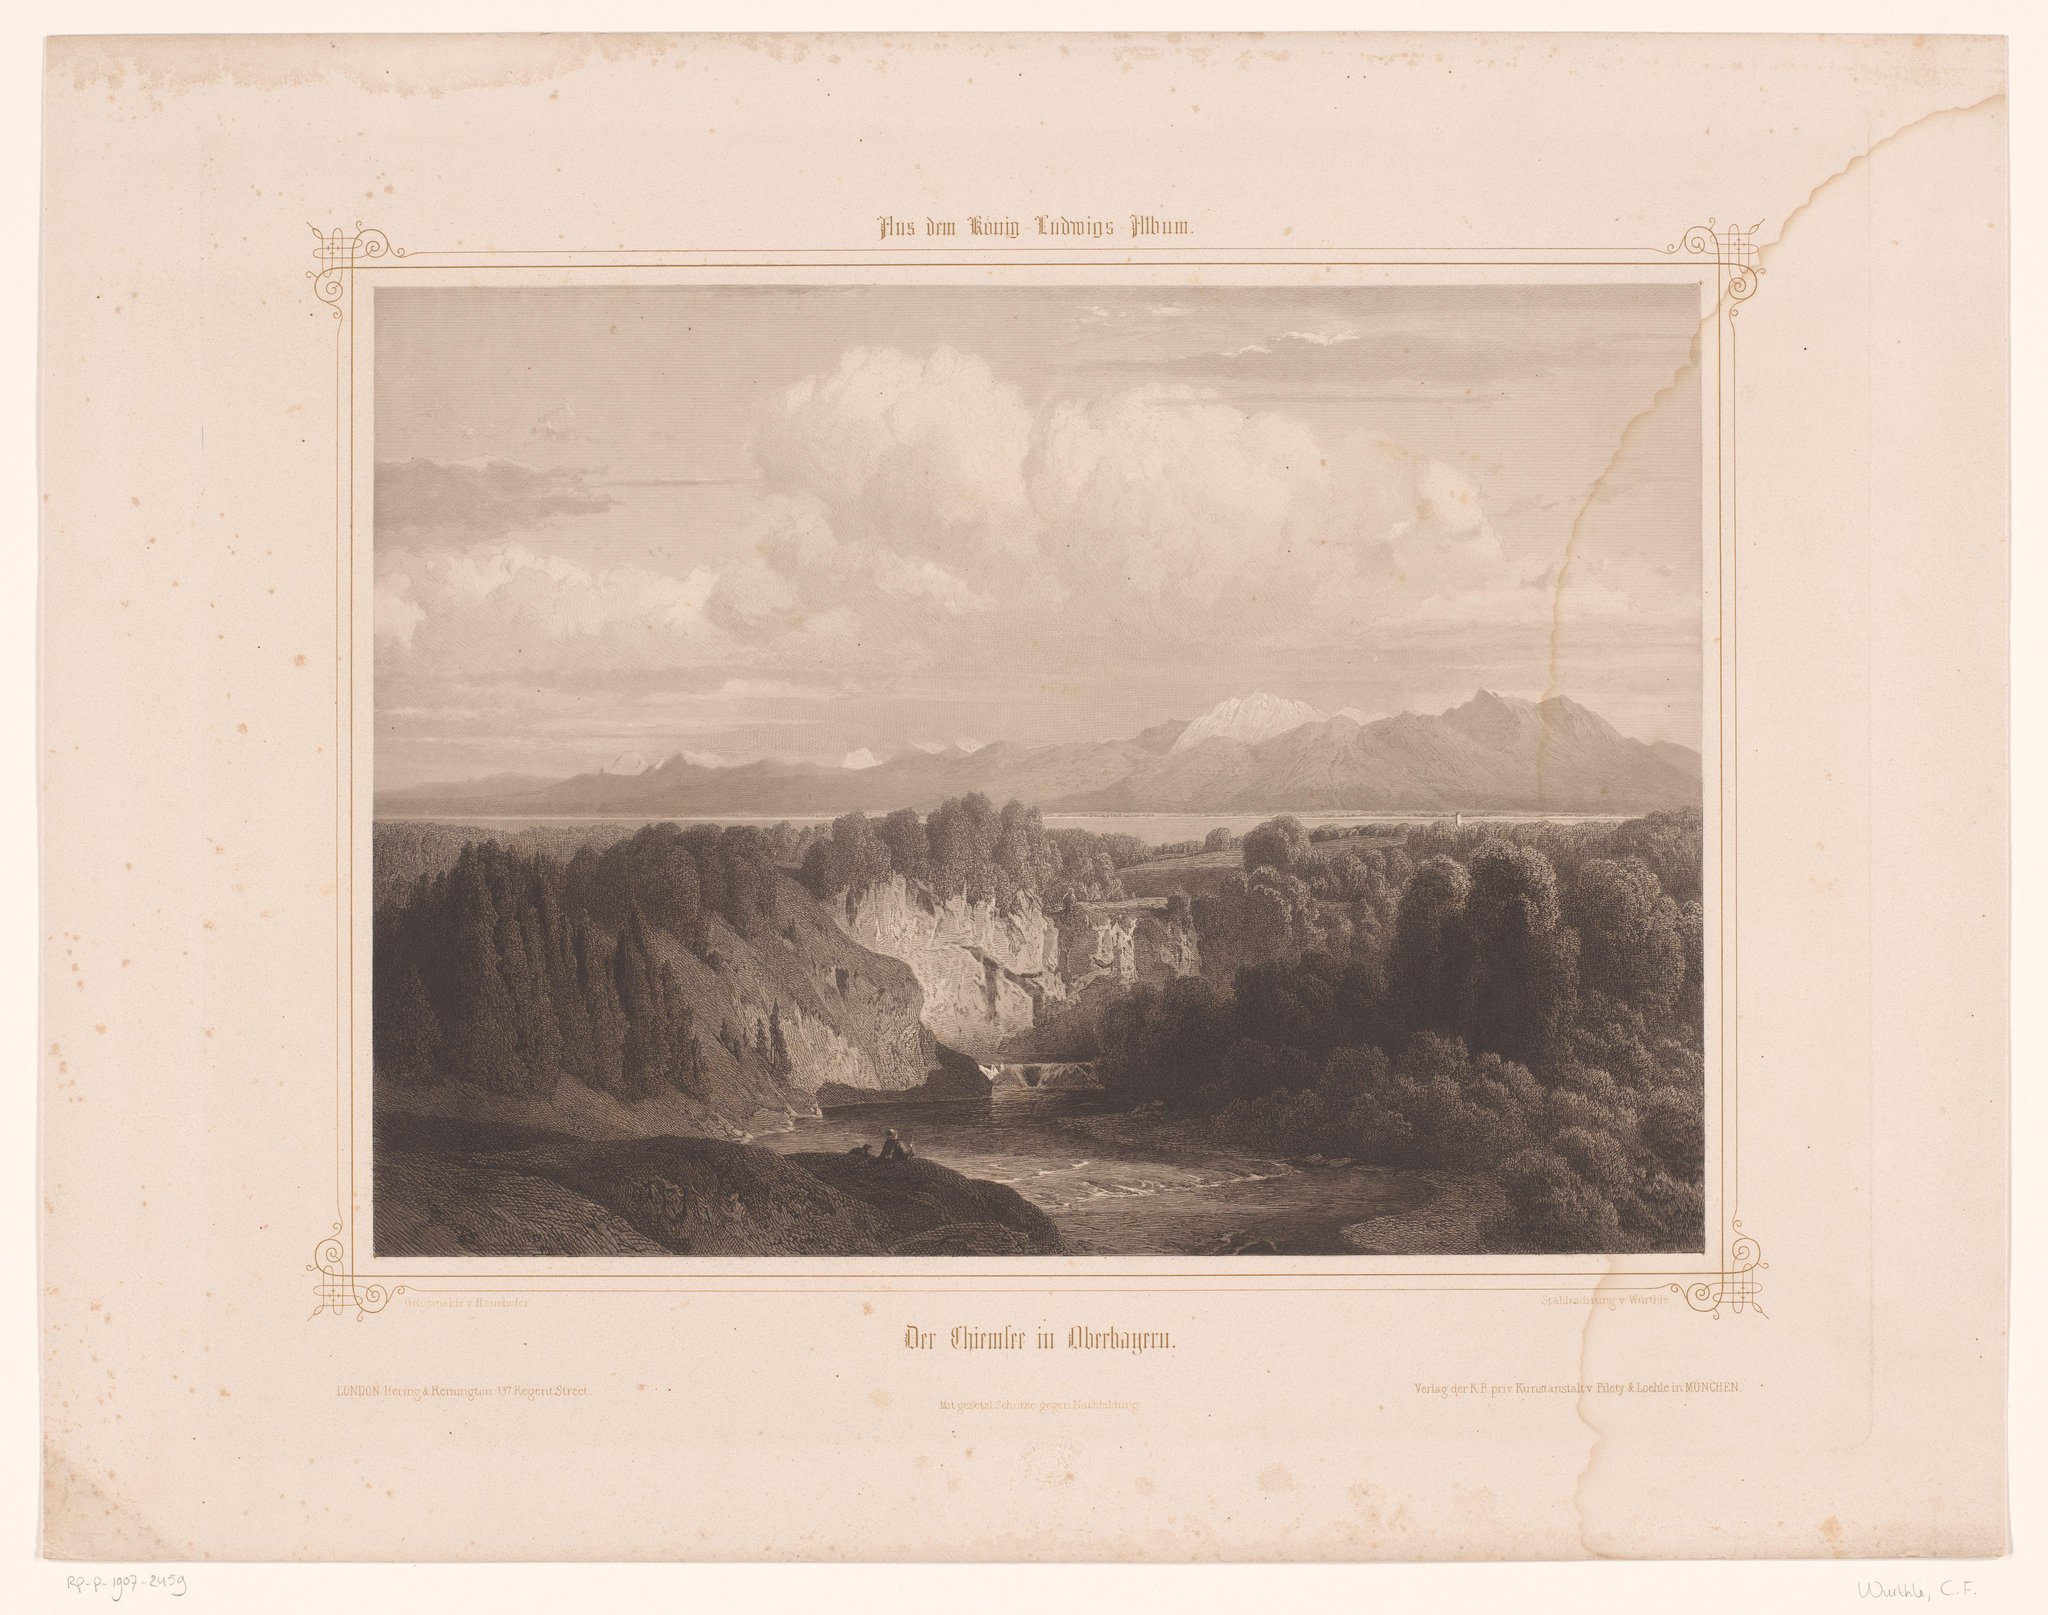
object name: print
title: Gezicht op de Chiemsee in Beieren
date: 1850-1859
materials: paper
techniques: aquatint, lithograph, engraving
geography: munich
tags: lodewijk i (koning van beieren), landscapes, lake, mountains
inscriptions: collector's mark: Lugt 2228, check stamp: ‘Piloty & Loehle München’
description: Prent afkomstig uit de serie 'Album Seiner Majestät des Königs Ludwig I. von Bayern', verschenen in verschillende afleveringen. De prenten gaan terug op het album dat Lodewijk I van Beieren op 9 oktober 1850 kreeg overhandigd van verschillende kunstenaars.